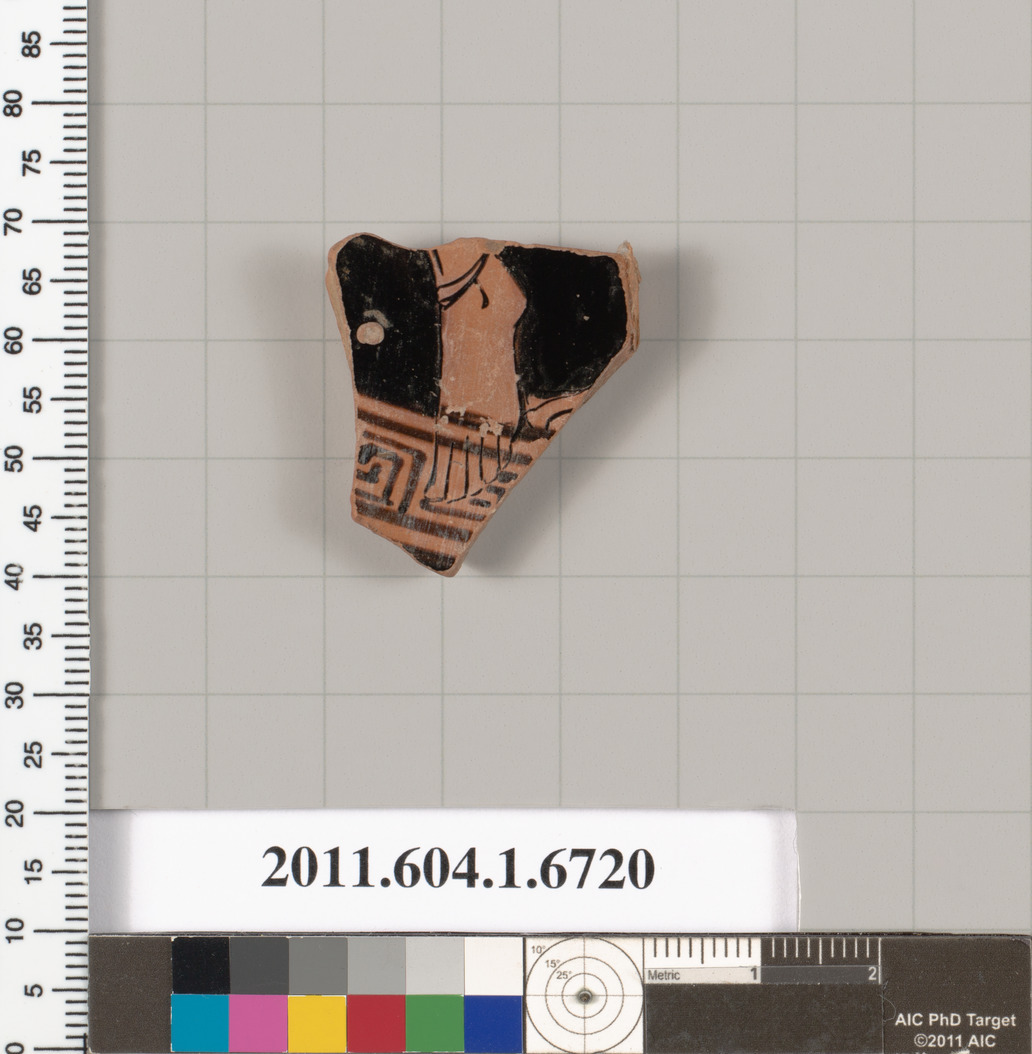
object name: kylix fragment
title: Terracotta fragment of a kylix (drinking cup)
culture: greek, attic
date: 490-470 BCE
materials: terracotta